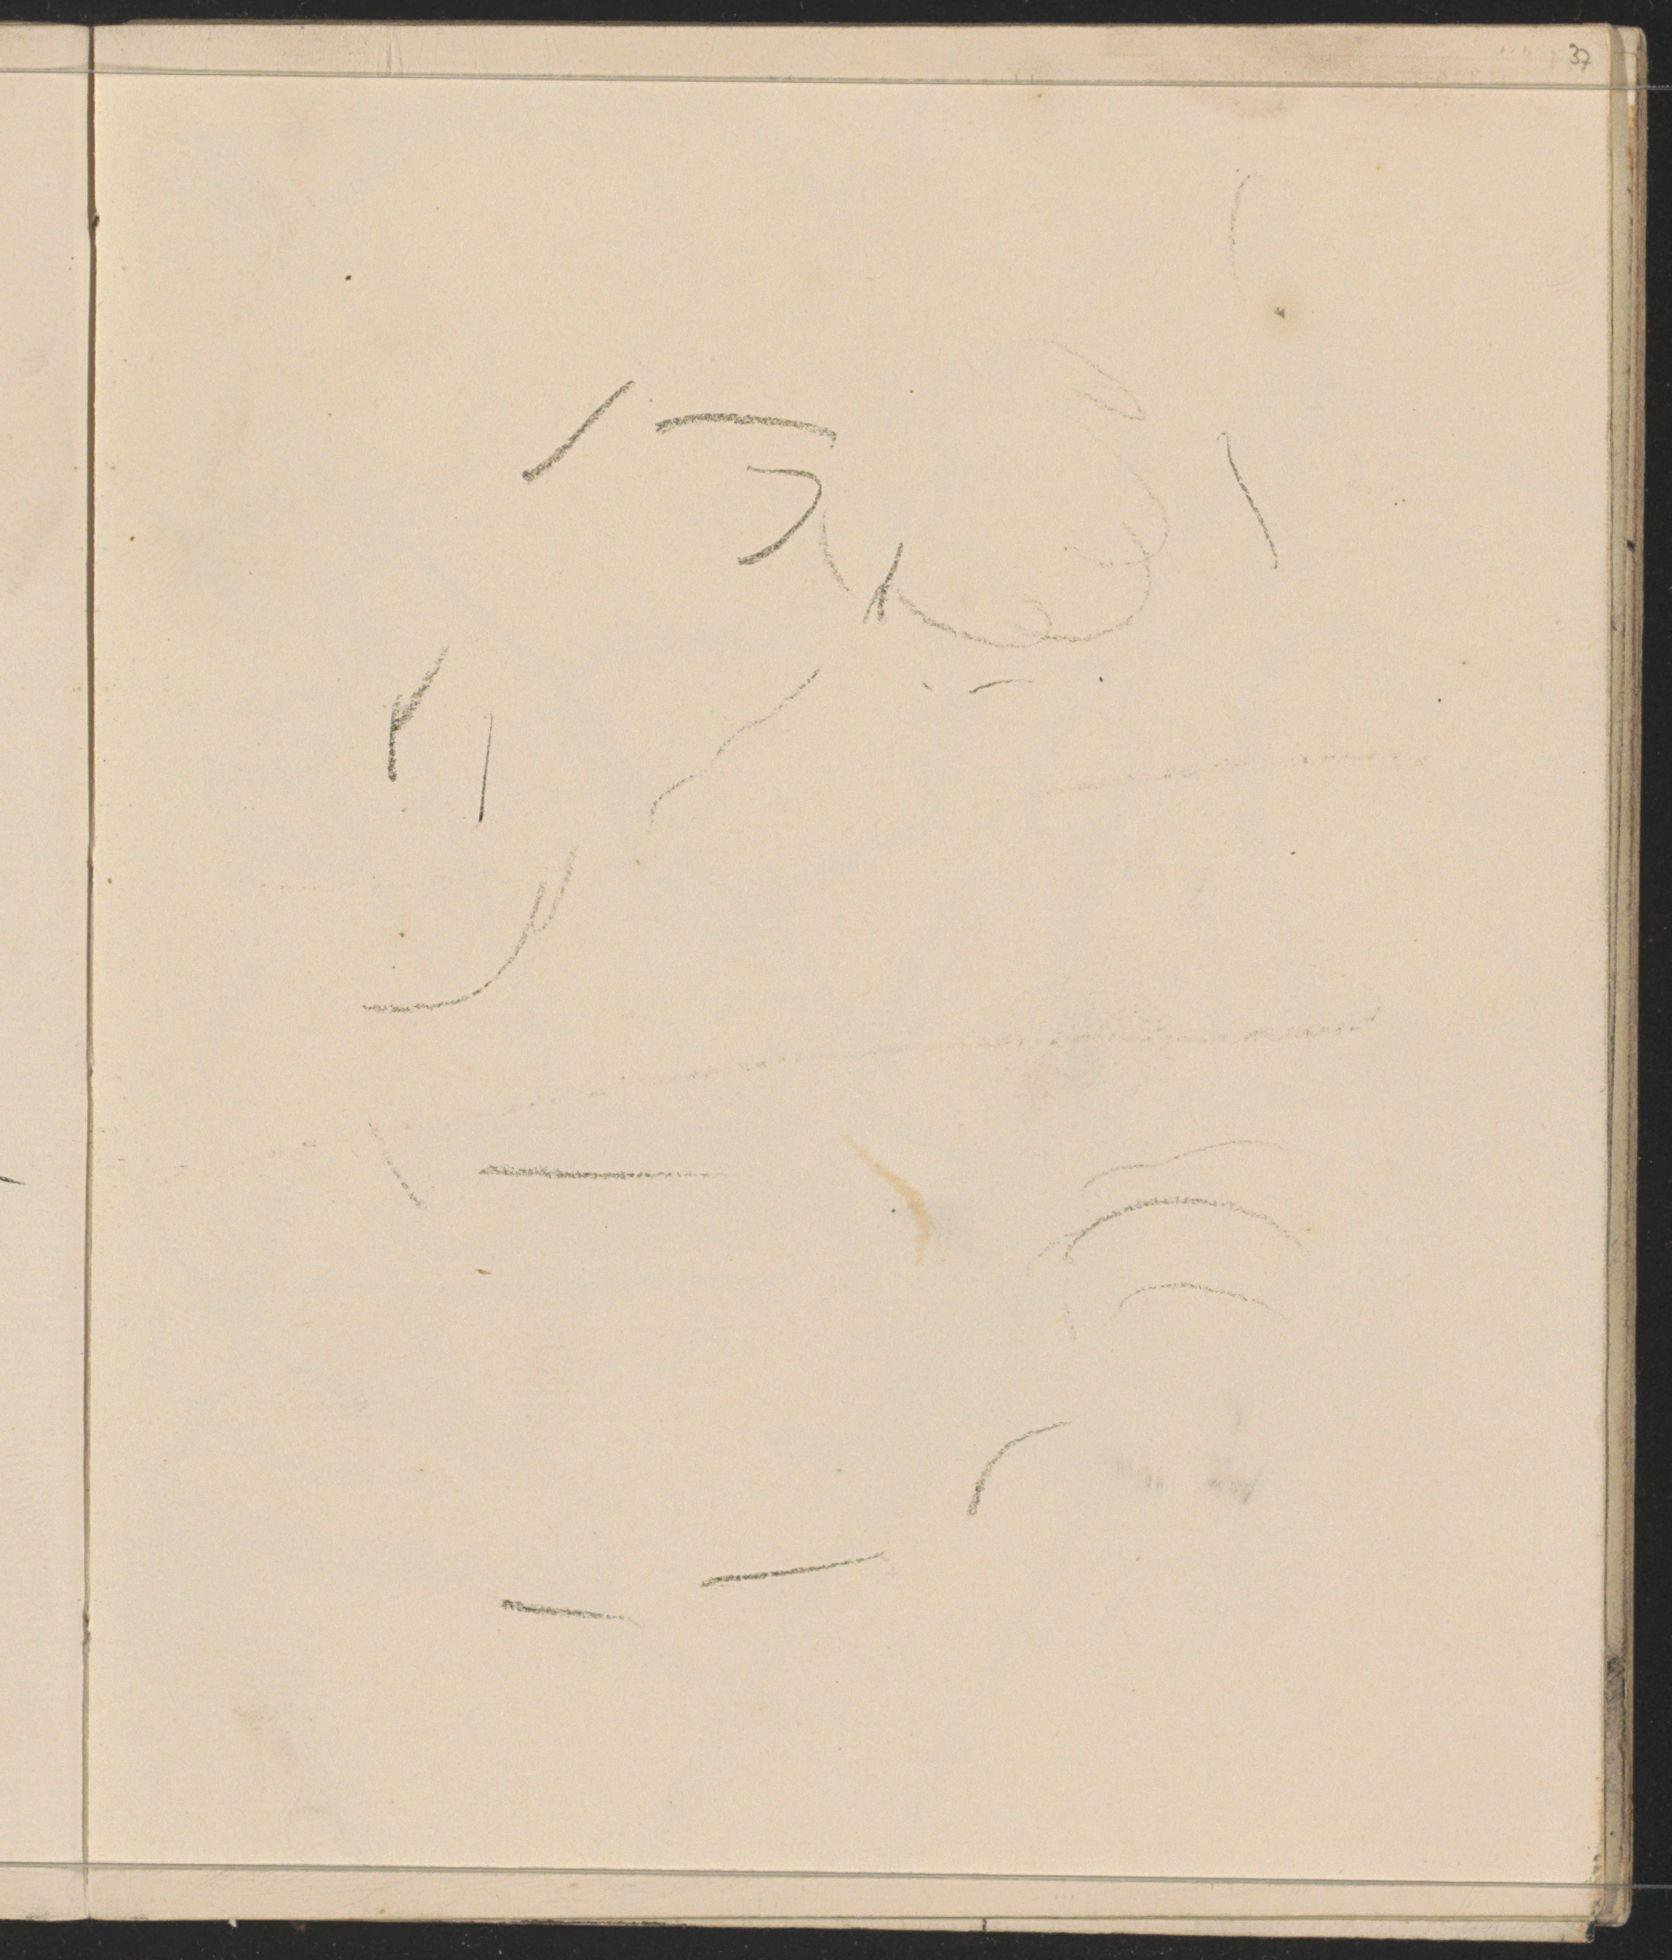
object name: sketchbook leaf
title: Twee figuurstudies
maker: isaac israels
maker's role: draughtsman, painter, print maker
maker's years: 1865-1934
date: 1886-1903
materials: chalk, paper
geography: amsterdam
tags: the (nude) human figure; 'corpo humano' (ripa)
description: Pagina 37 uit schetsboek XXXII met 92 pagina's.